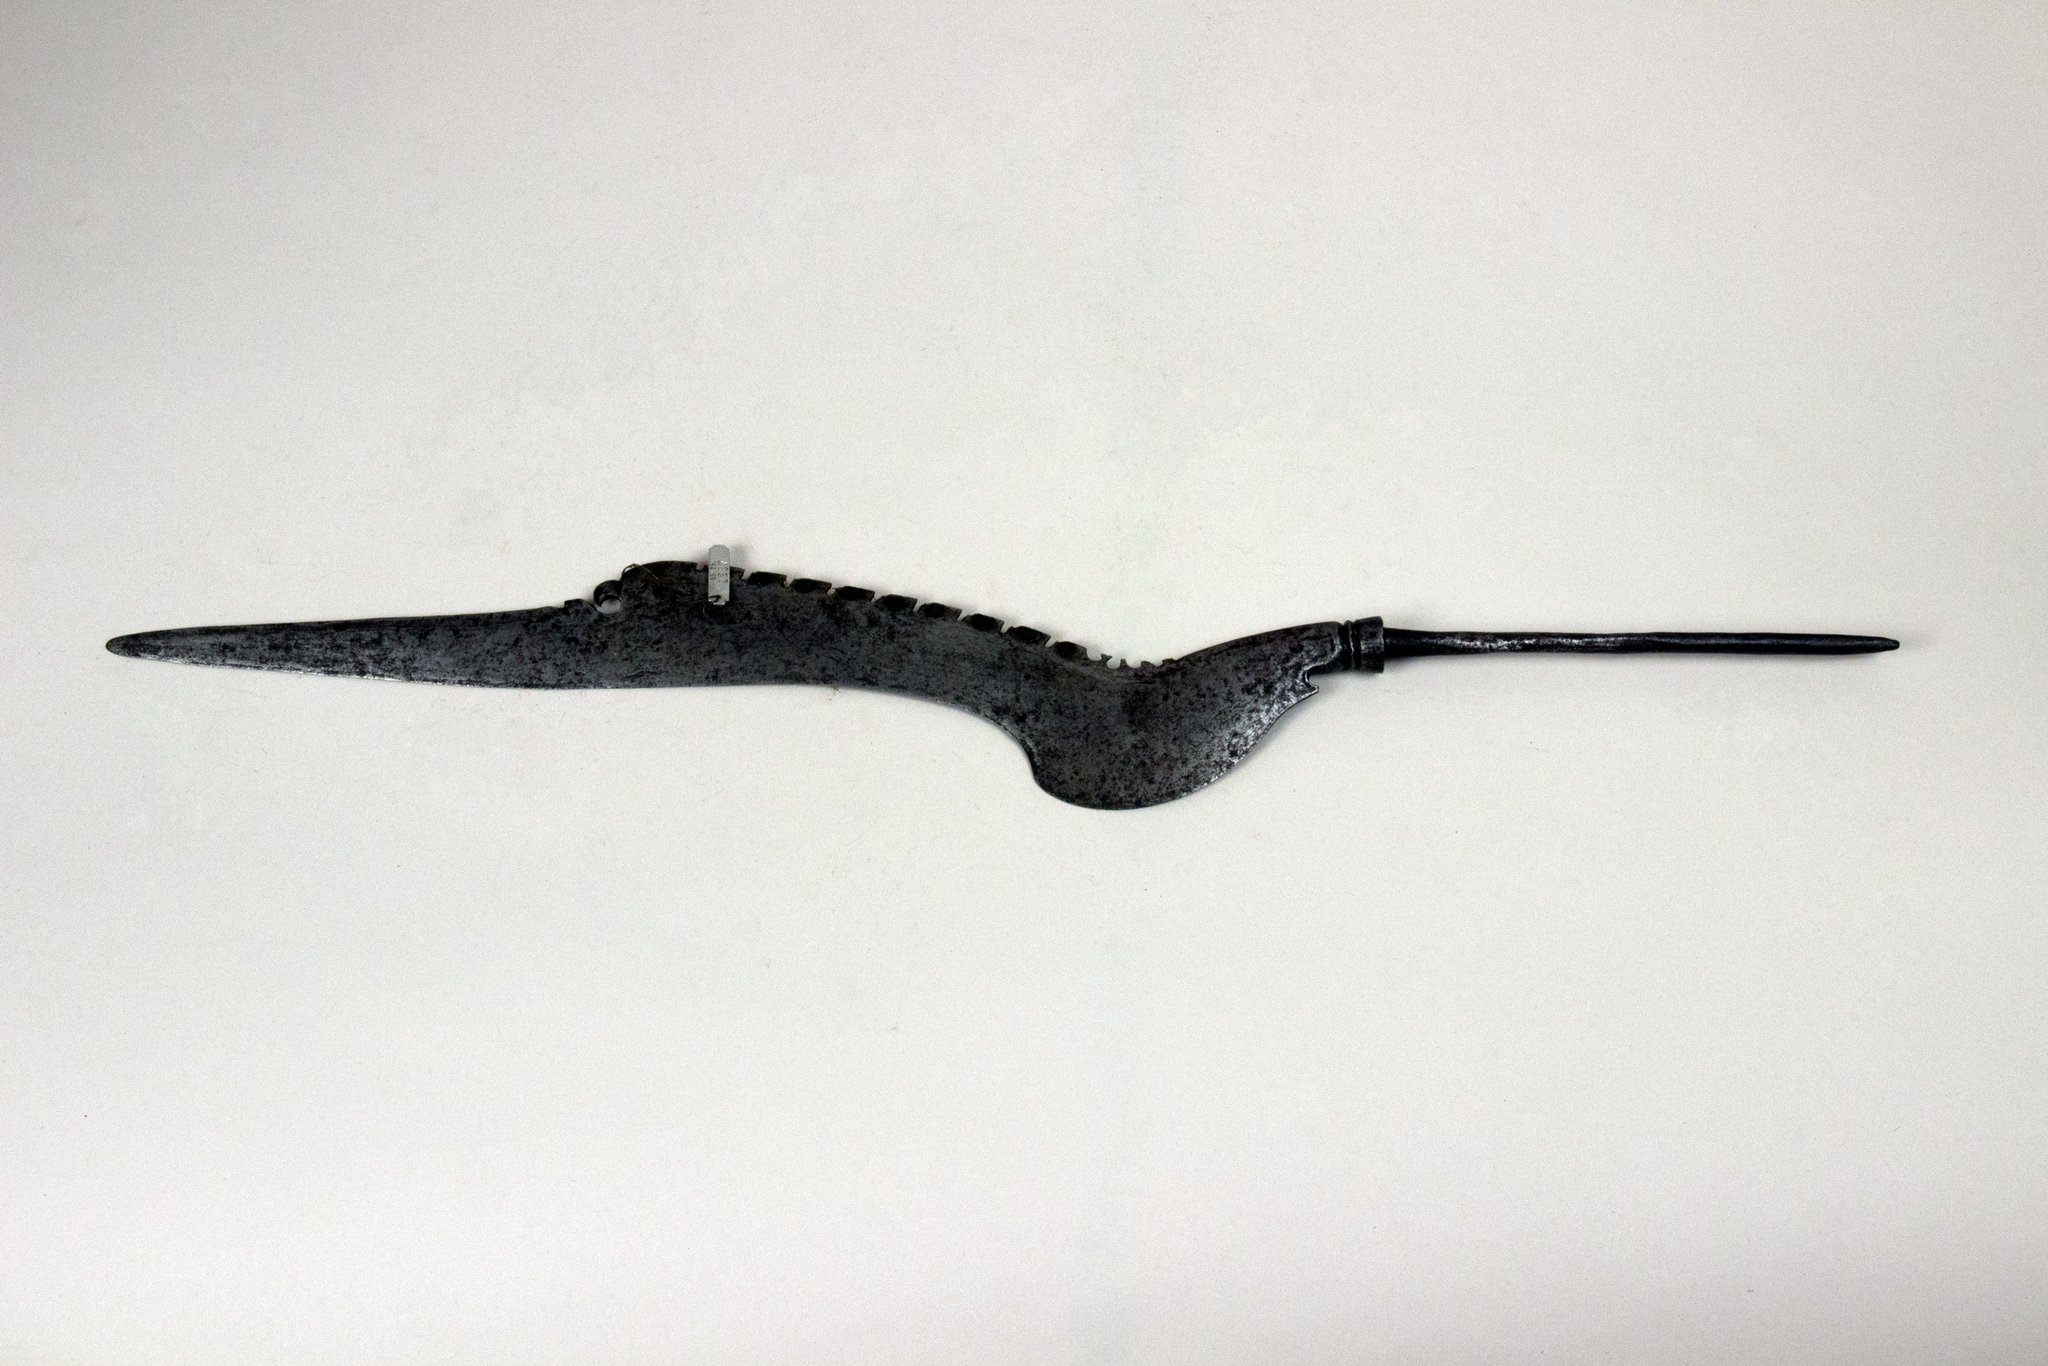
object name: blade kudi tranchang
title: Blade (Kudi tranchang)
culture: javanese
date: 1501-1900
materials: brass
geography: indonesia